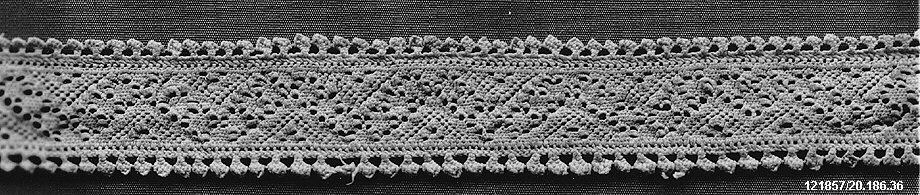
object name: strip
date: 1501-1600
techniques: lace